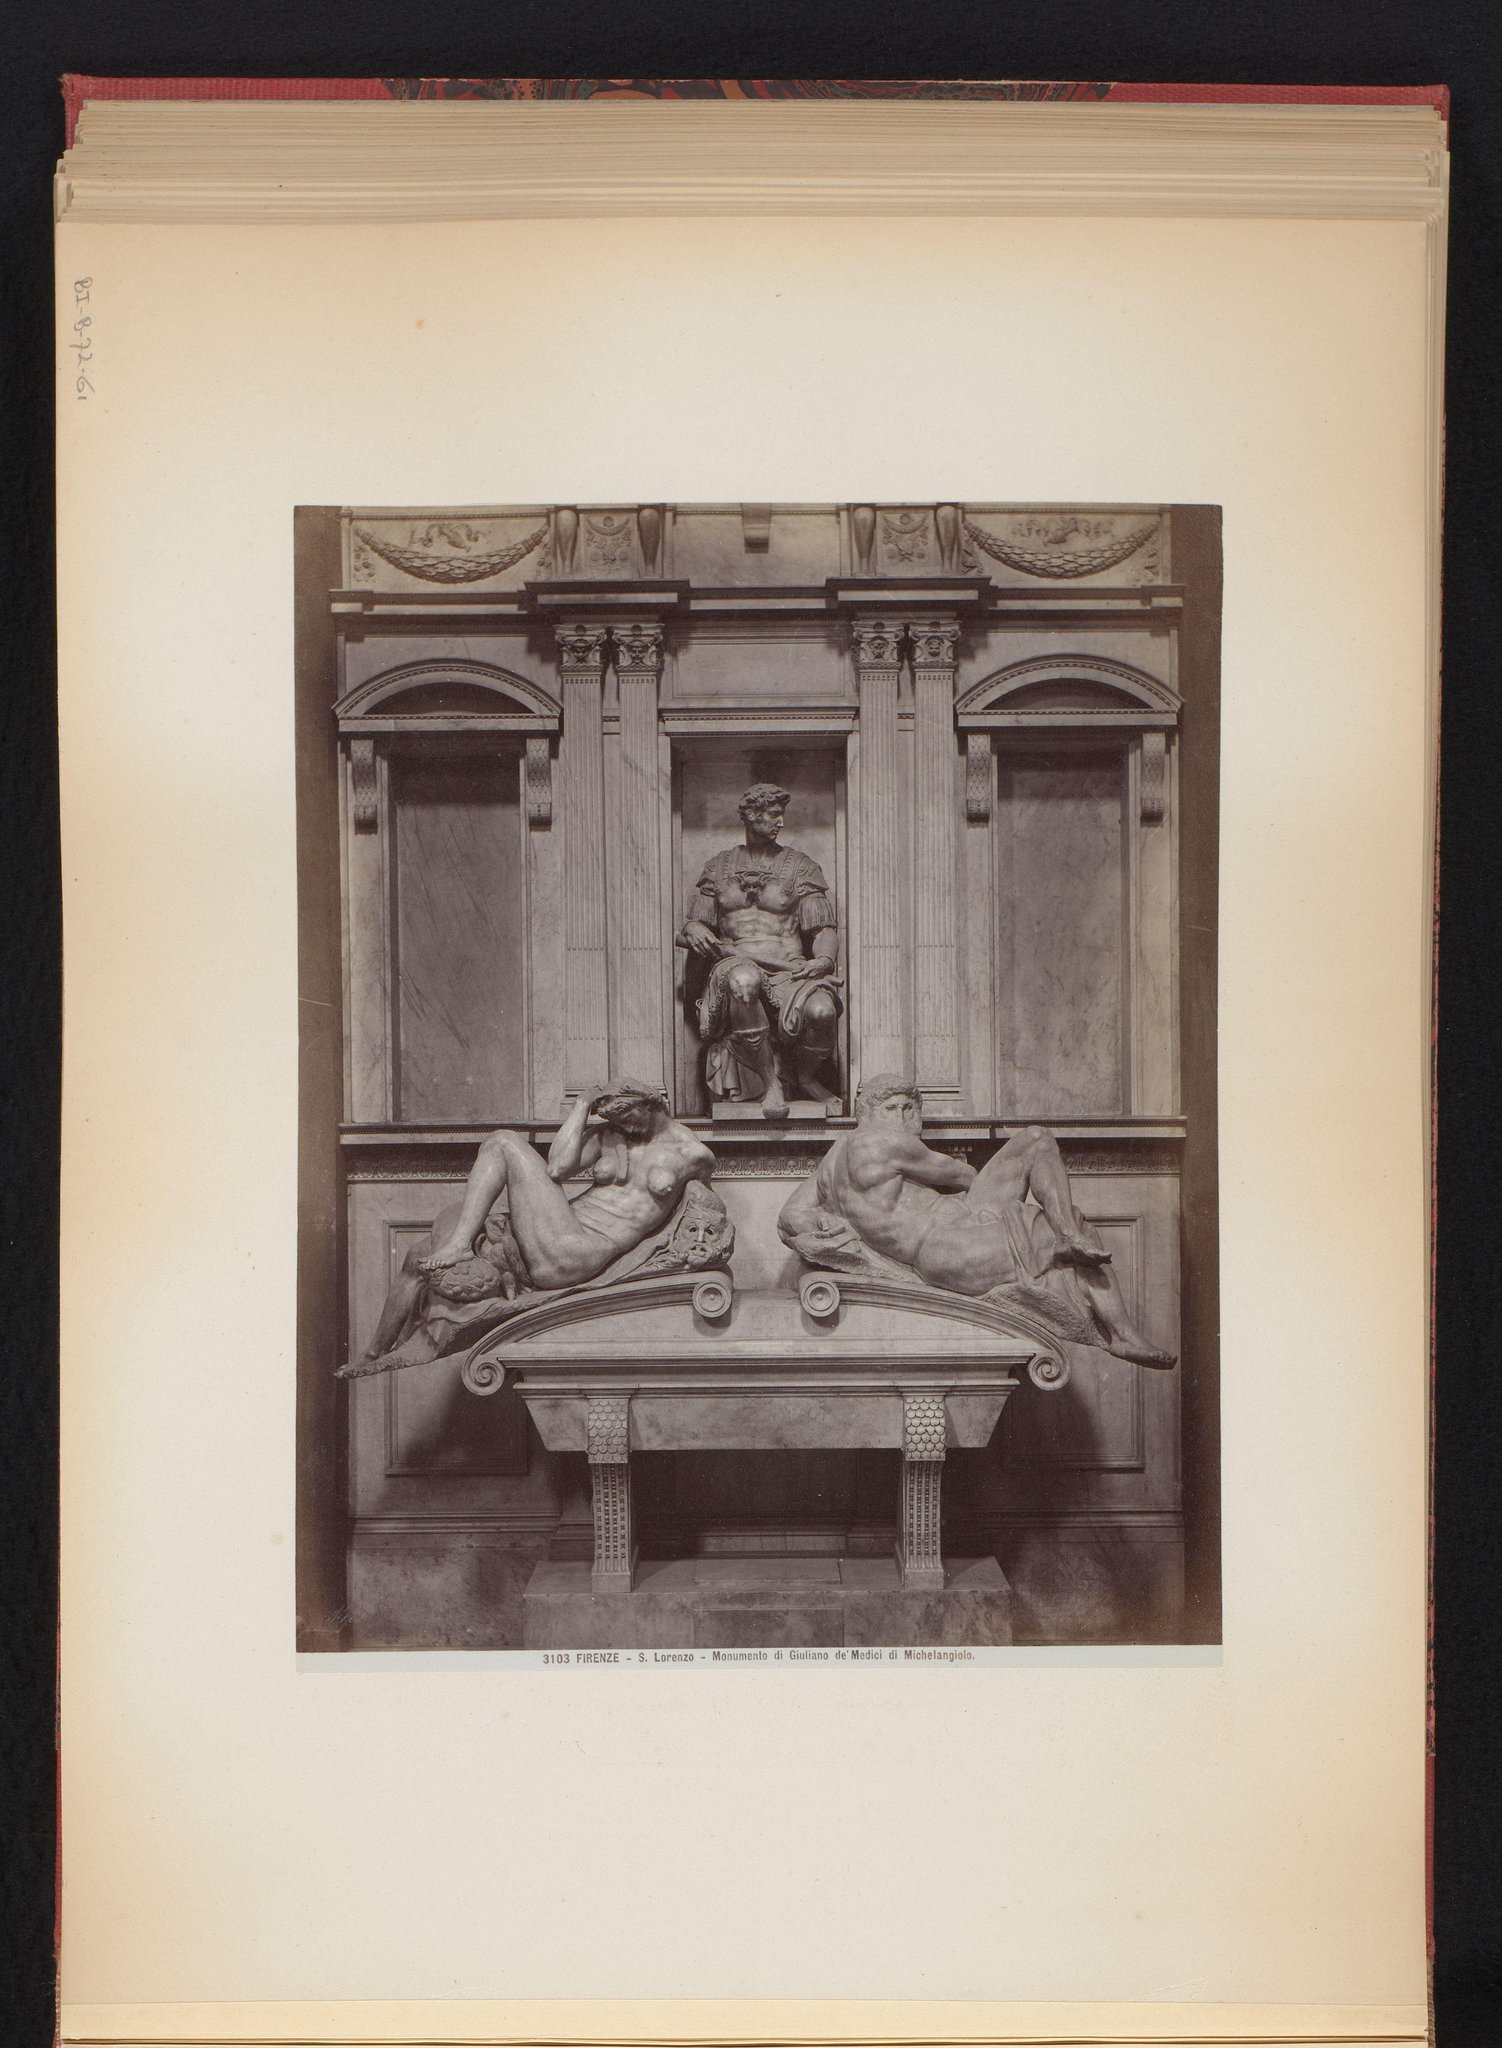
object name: album leaf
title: Firenze - S. Lorenzo - Monumento di Giuliano de'Medici di Michelangiolo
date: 1870-1881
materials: paper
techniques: albumen print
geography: florence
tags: politician, piece of sculpture, reproduction of a piece of sculpture, grave-building, monumental tomb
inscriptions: number: ‘3103’